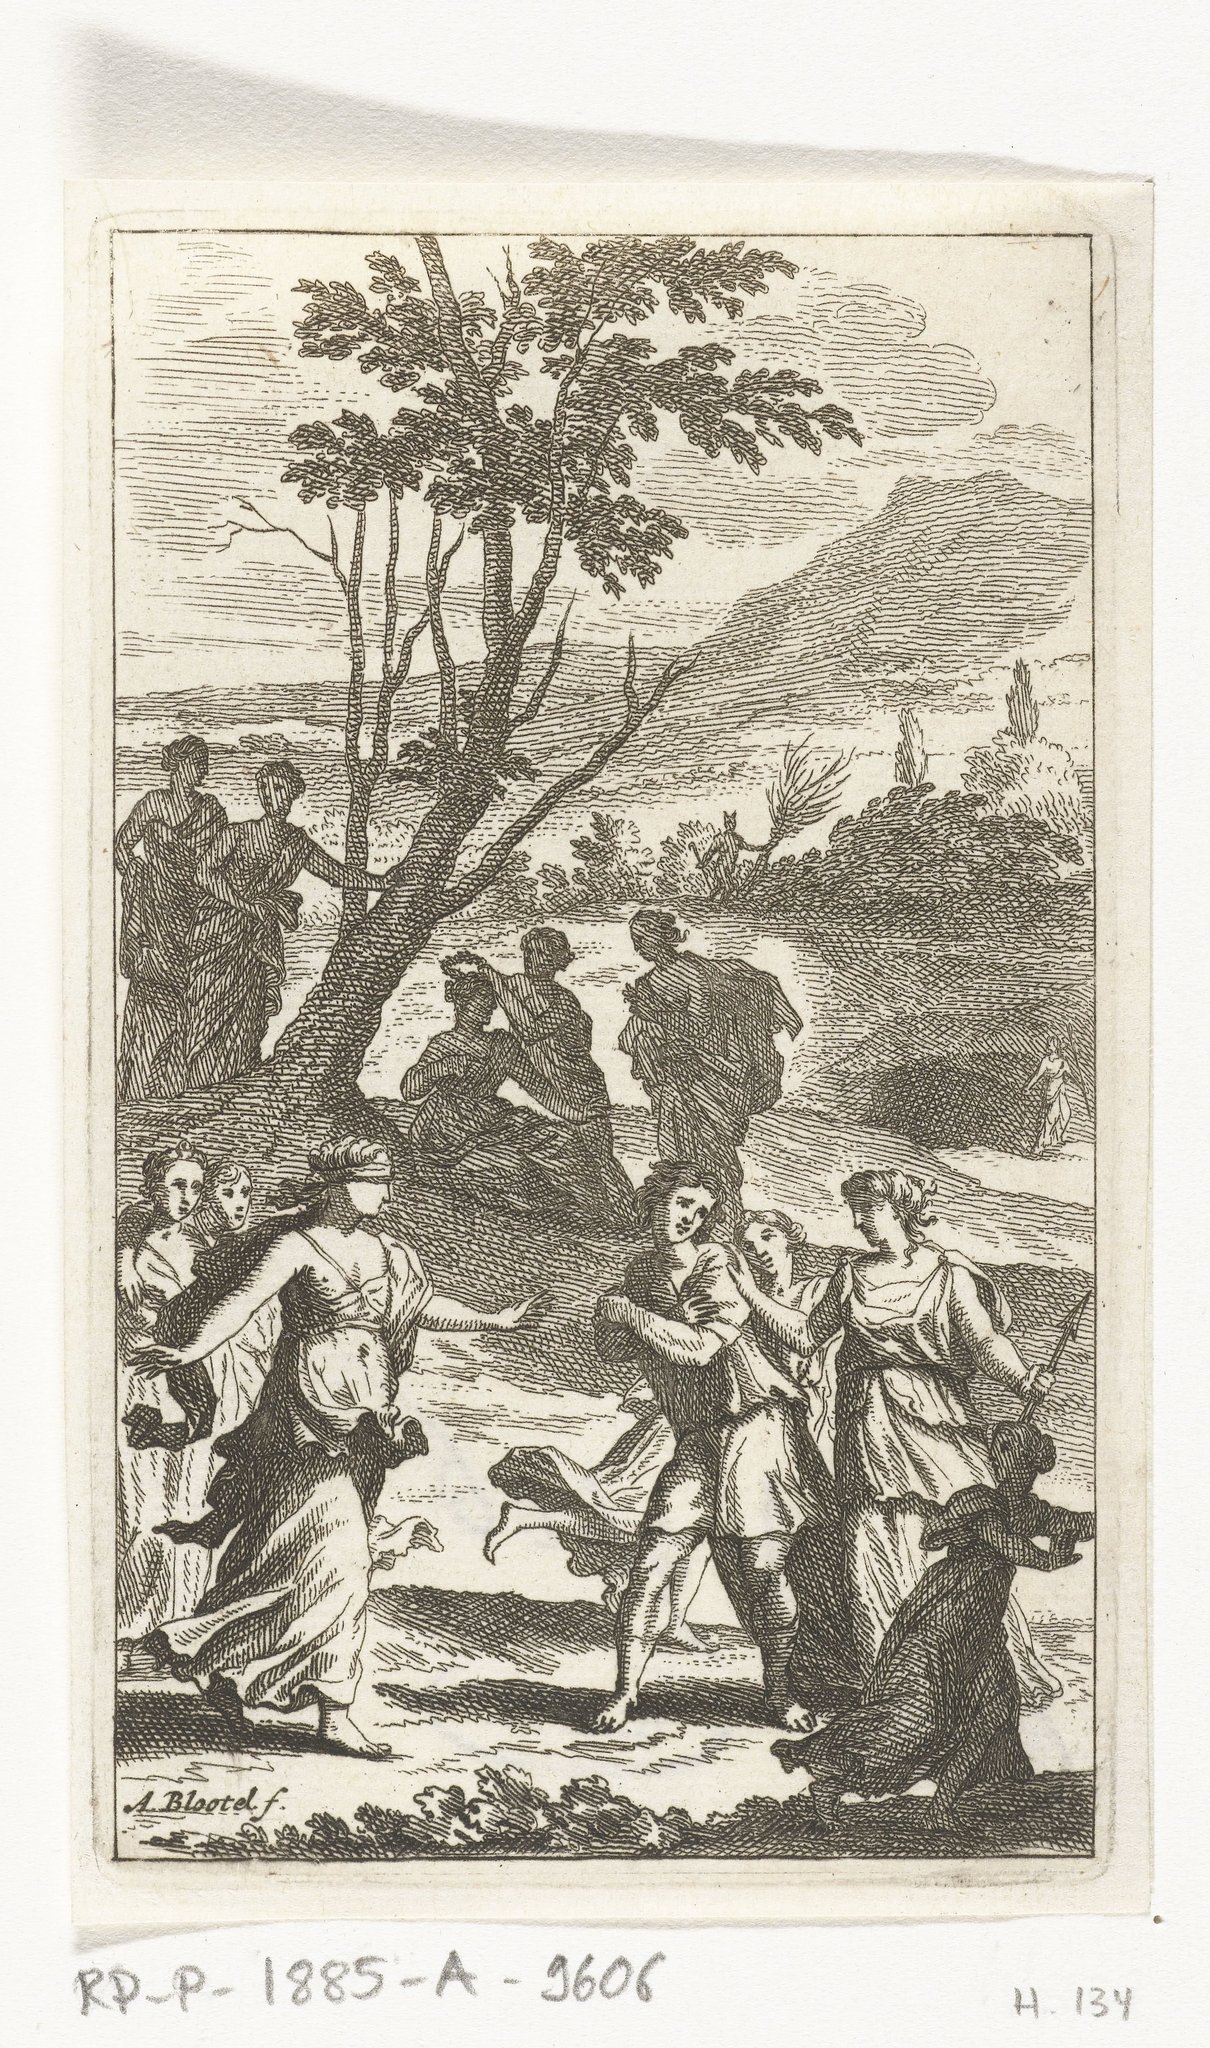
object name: print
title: Il pastor fido / Le berger fidele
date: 1677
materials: paper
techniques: engraving, etching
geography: cologne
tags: (scenes from) specific works of literature: guarini, pastor fido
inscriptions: collector's mark: Lugt 2228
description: Boekillustratie uit een Italiaanse of Franse editie van G.B. Guarini, Il pastor fido. Mogelijk uit de Franse editie: Le berger fidele, Keulen, P. Marteau, 1677 (fictief adres, eigenlijk gedrukt te Leiden bij de gebroeders Hackius).